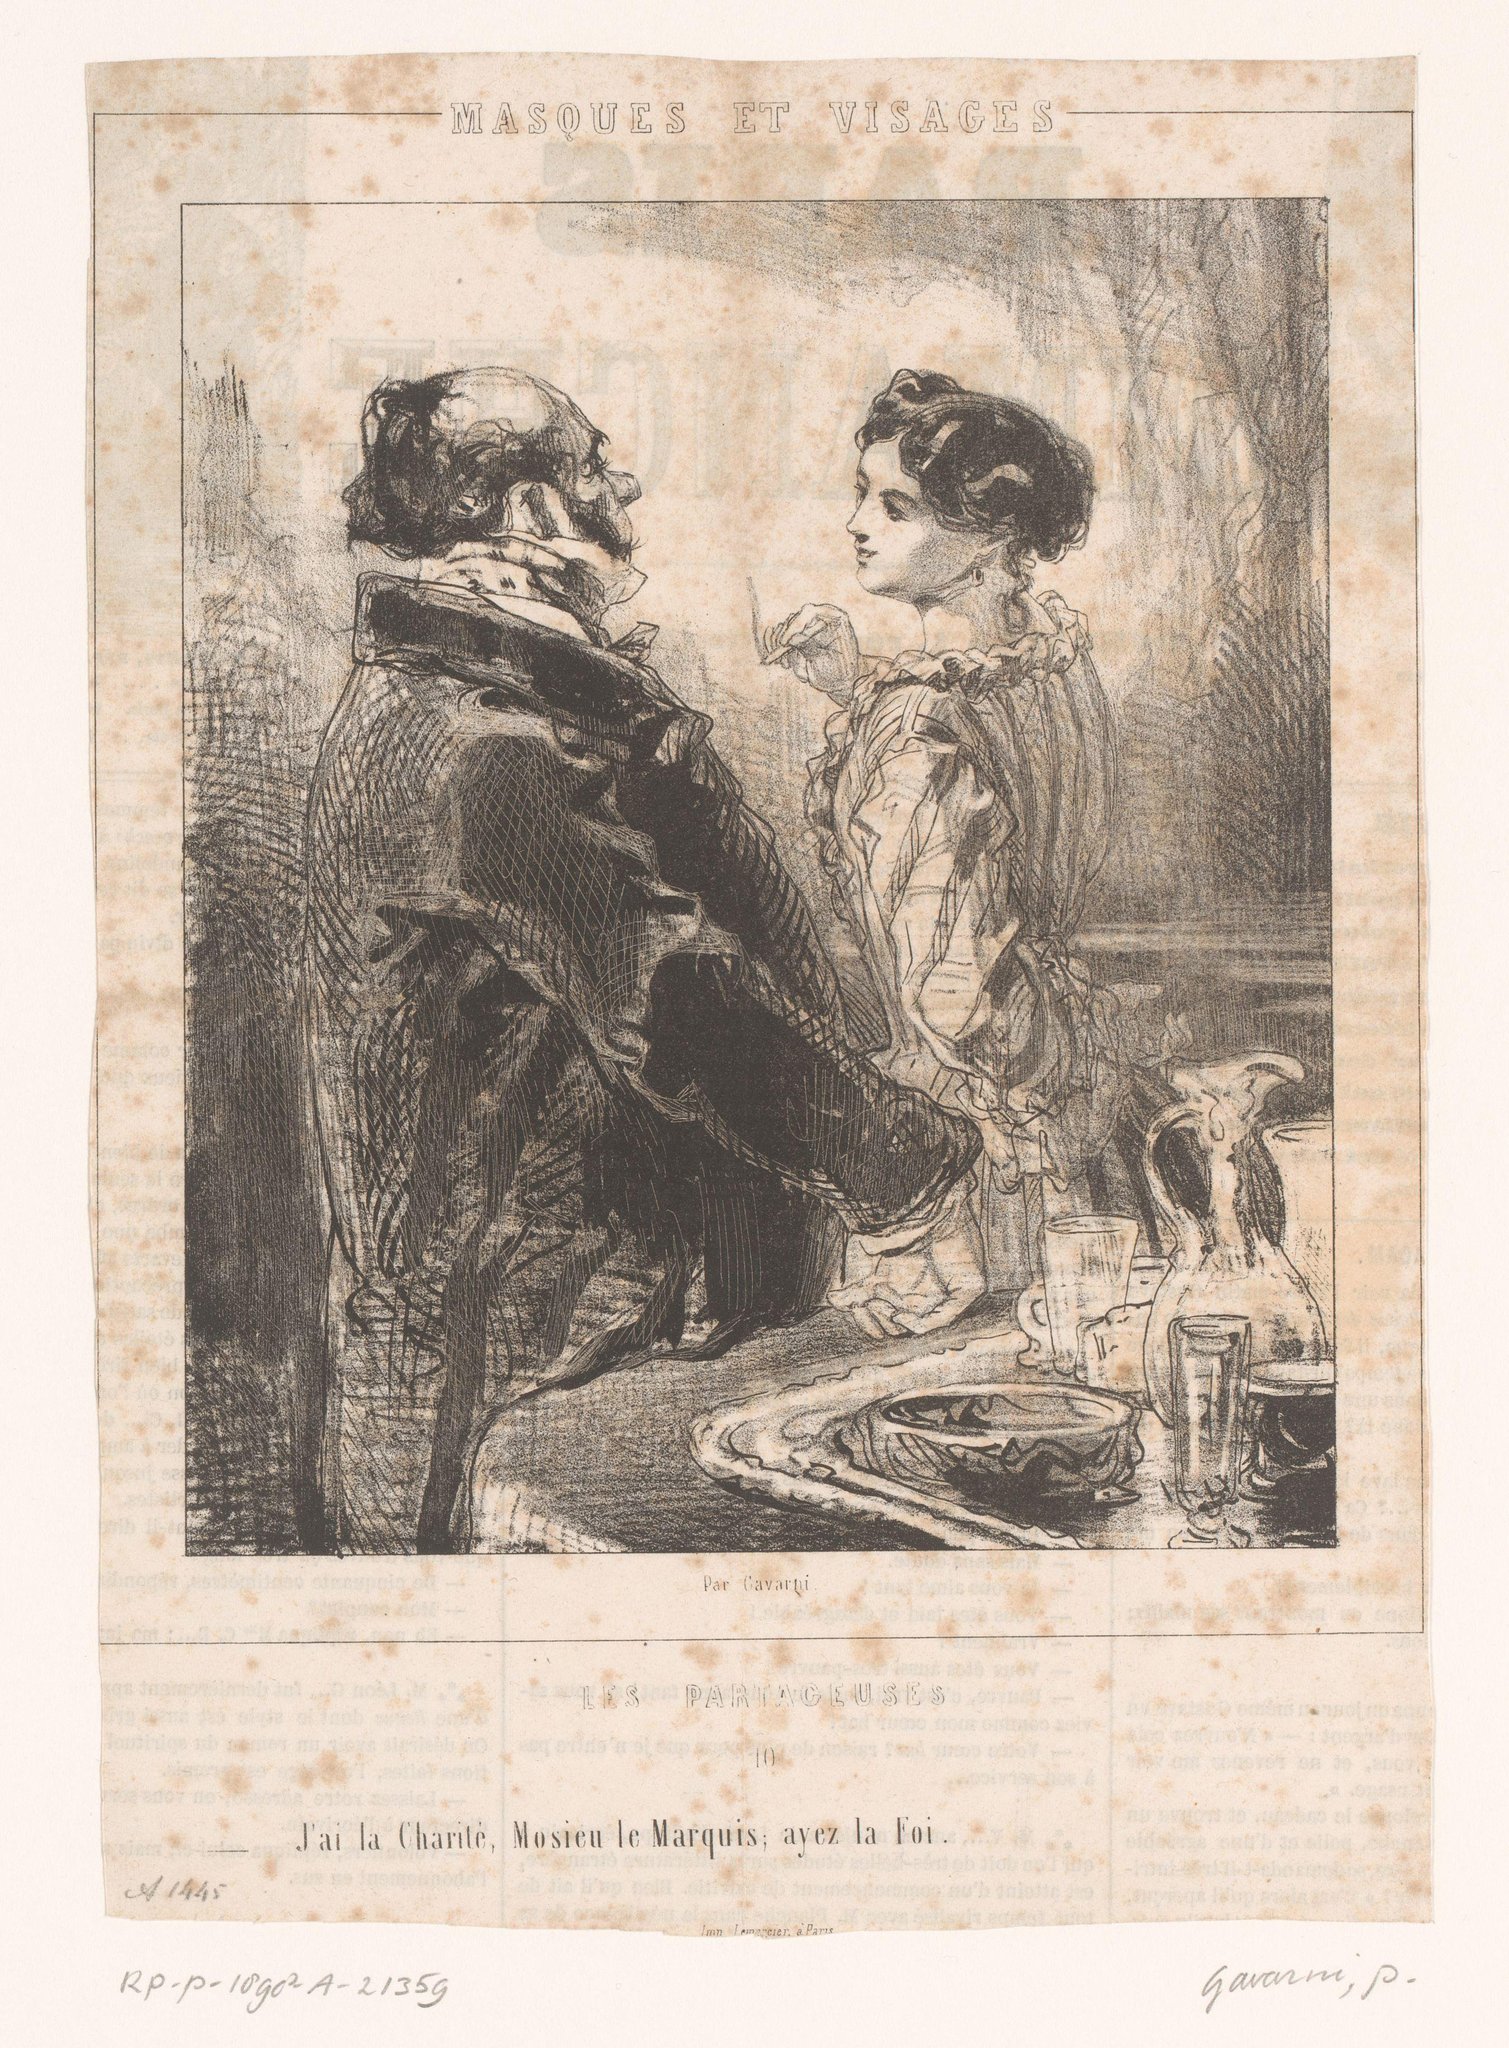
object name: cartoon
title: Deelgenoten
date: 1852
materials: paper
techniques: lithograph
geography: paris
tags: standing figure, cigarette, conversation, dialogue; conversation piece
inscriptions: collector's mark: Lugt 964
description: Prent gebruikt voor: Paris (journal), 14 november 1852.